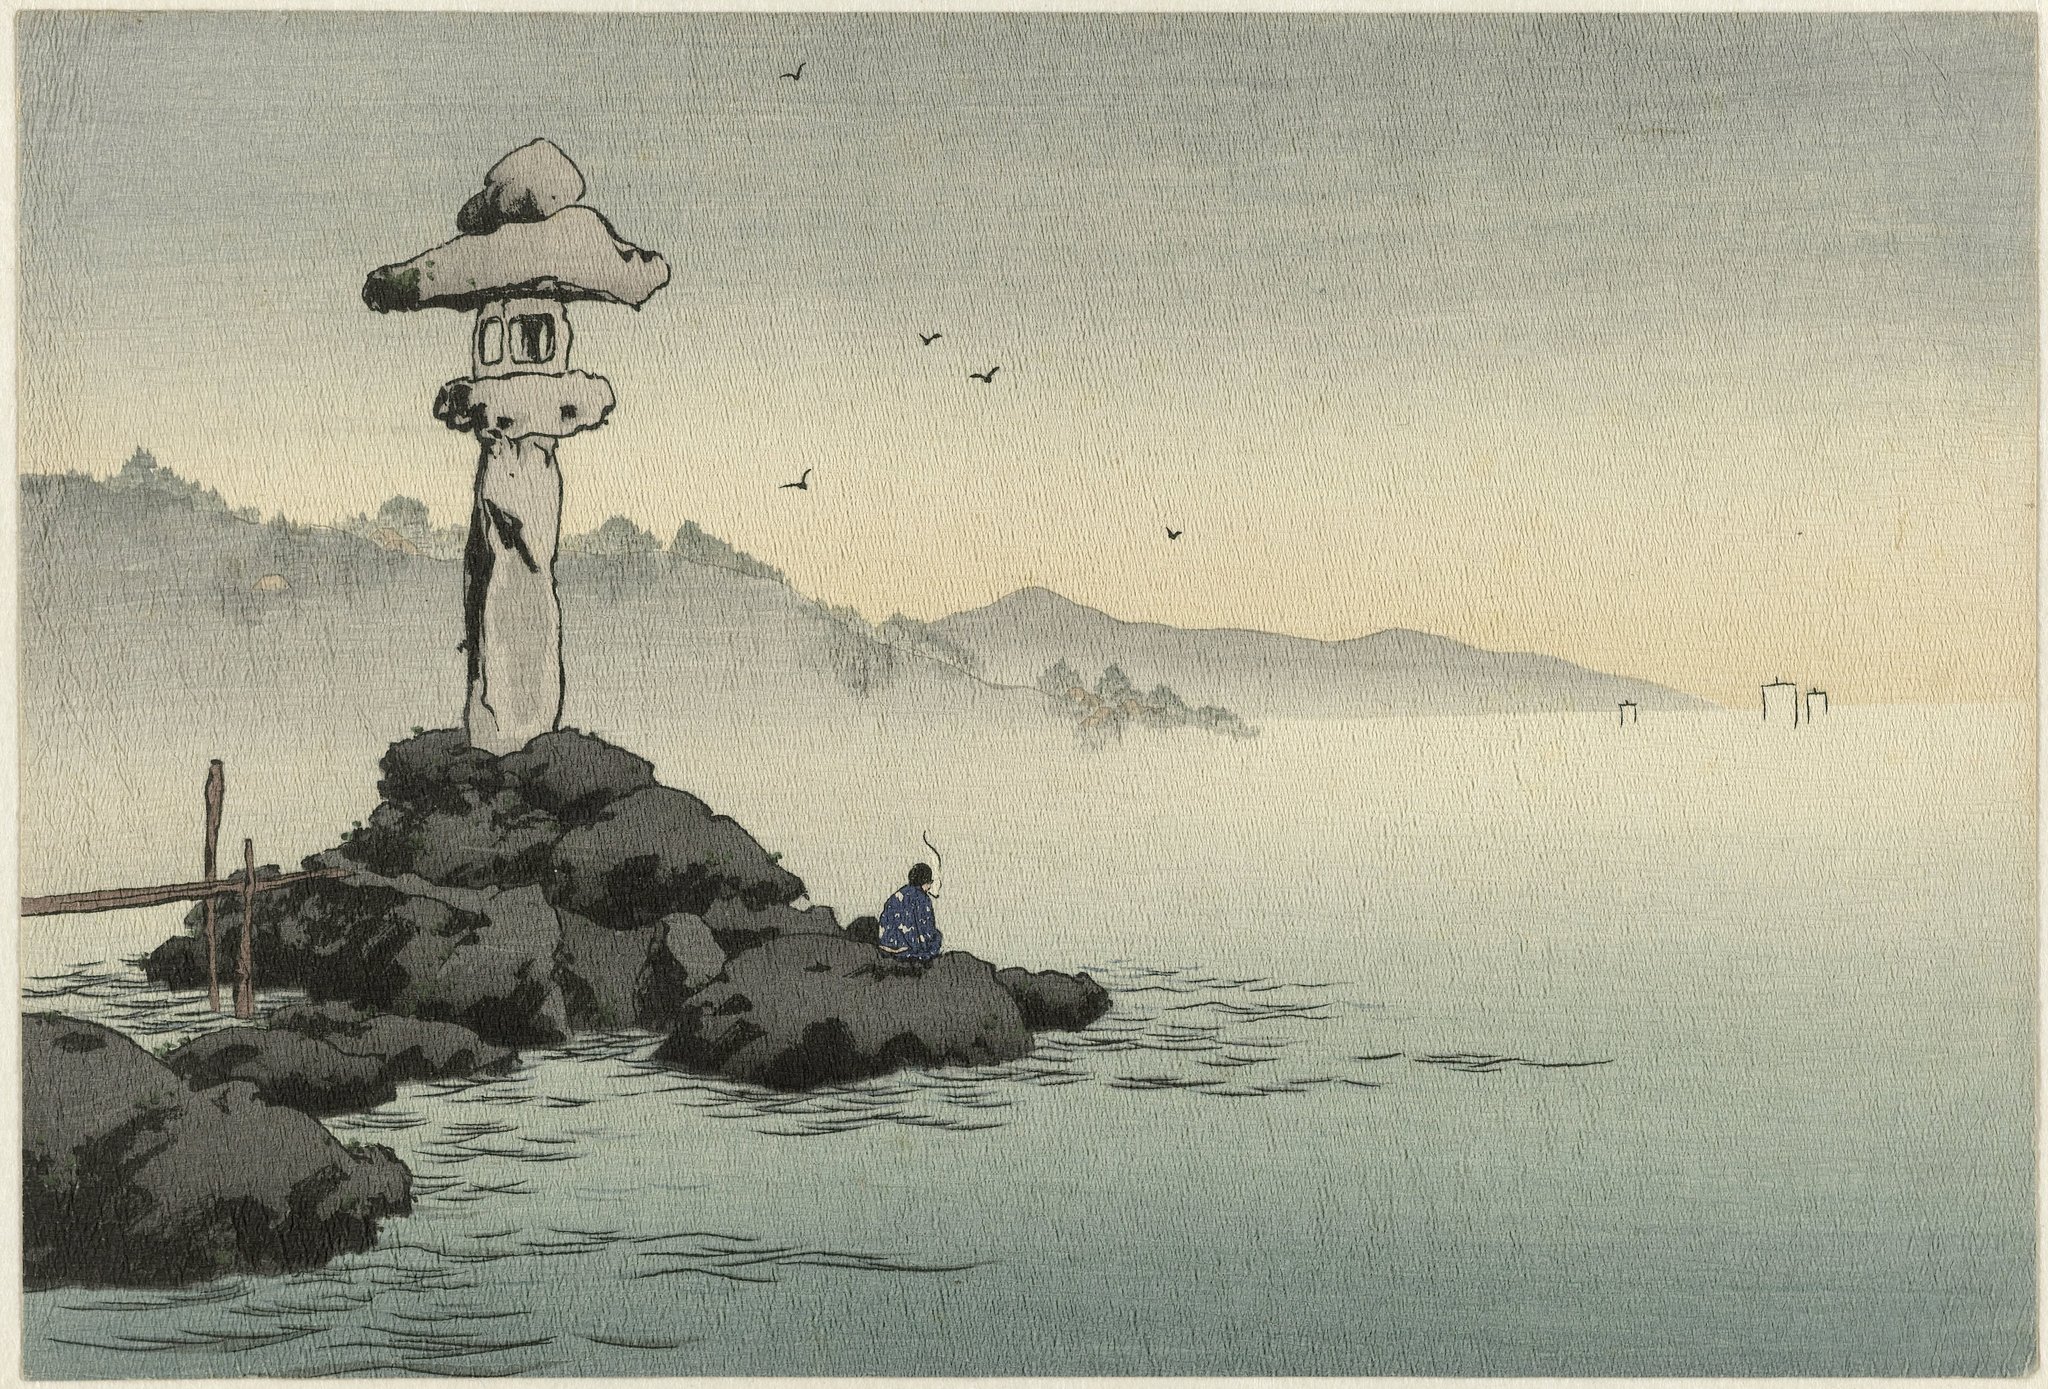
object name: print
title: Lantaren op een rots aan de kust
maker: Anonymous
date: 1890-1900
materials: paper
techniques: woodcut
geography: japan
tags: sailing-ship, sailing-boat, rocky coast, beacon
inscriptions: collector's mark: Lugt 2228, number: ‘1916/5’, number: ‘1916 M5’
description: Crêpepapier prent van een lantaren op een uitstekende rots aan de kust, twee zeilschepen in de verte.